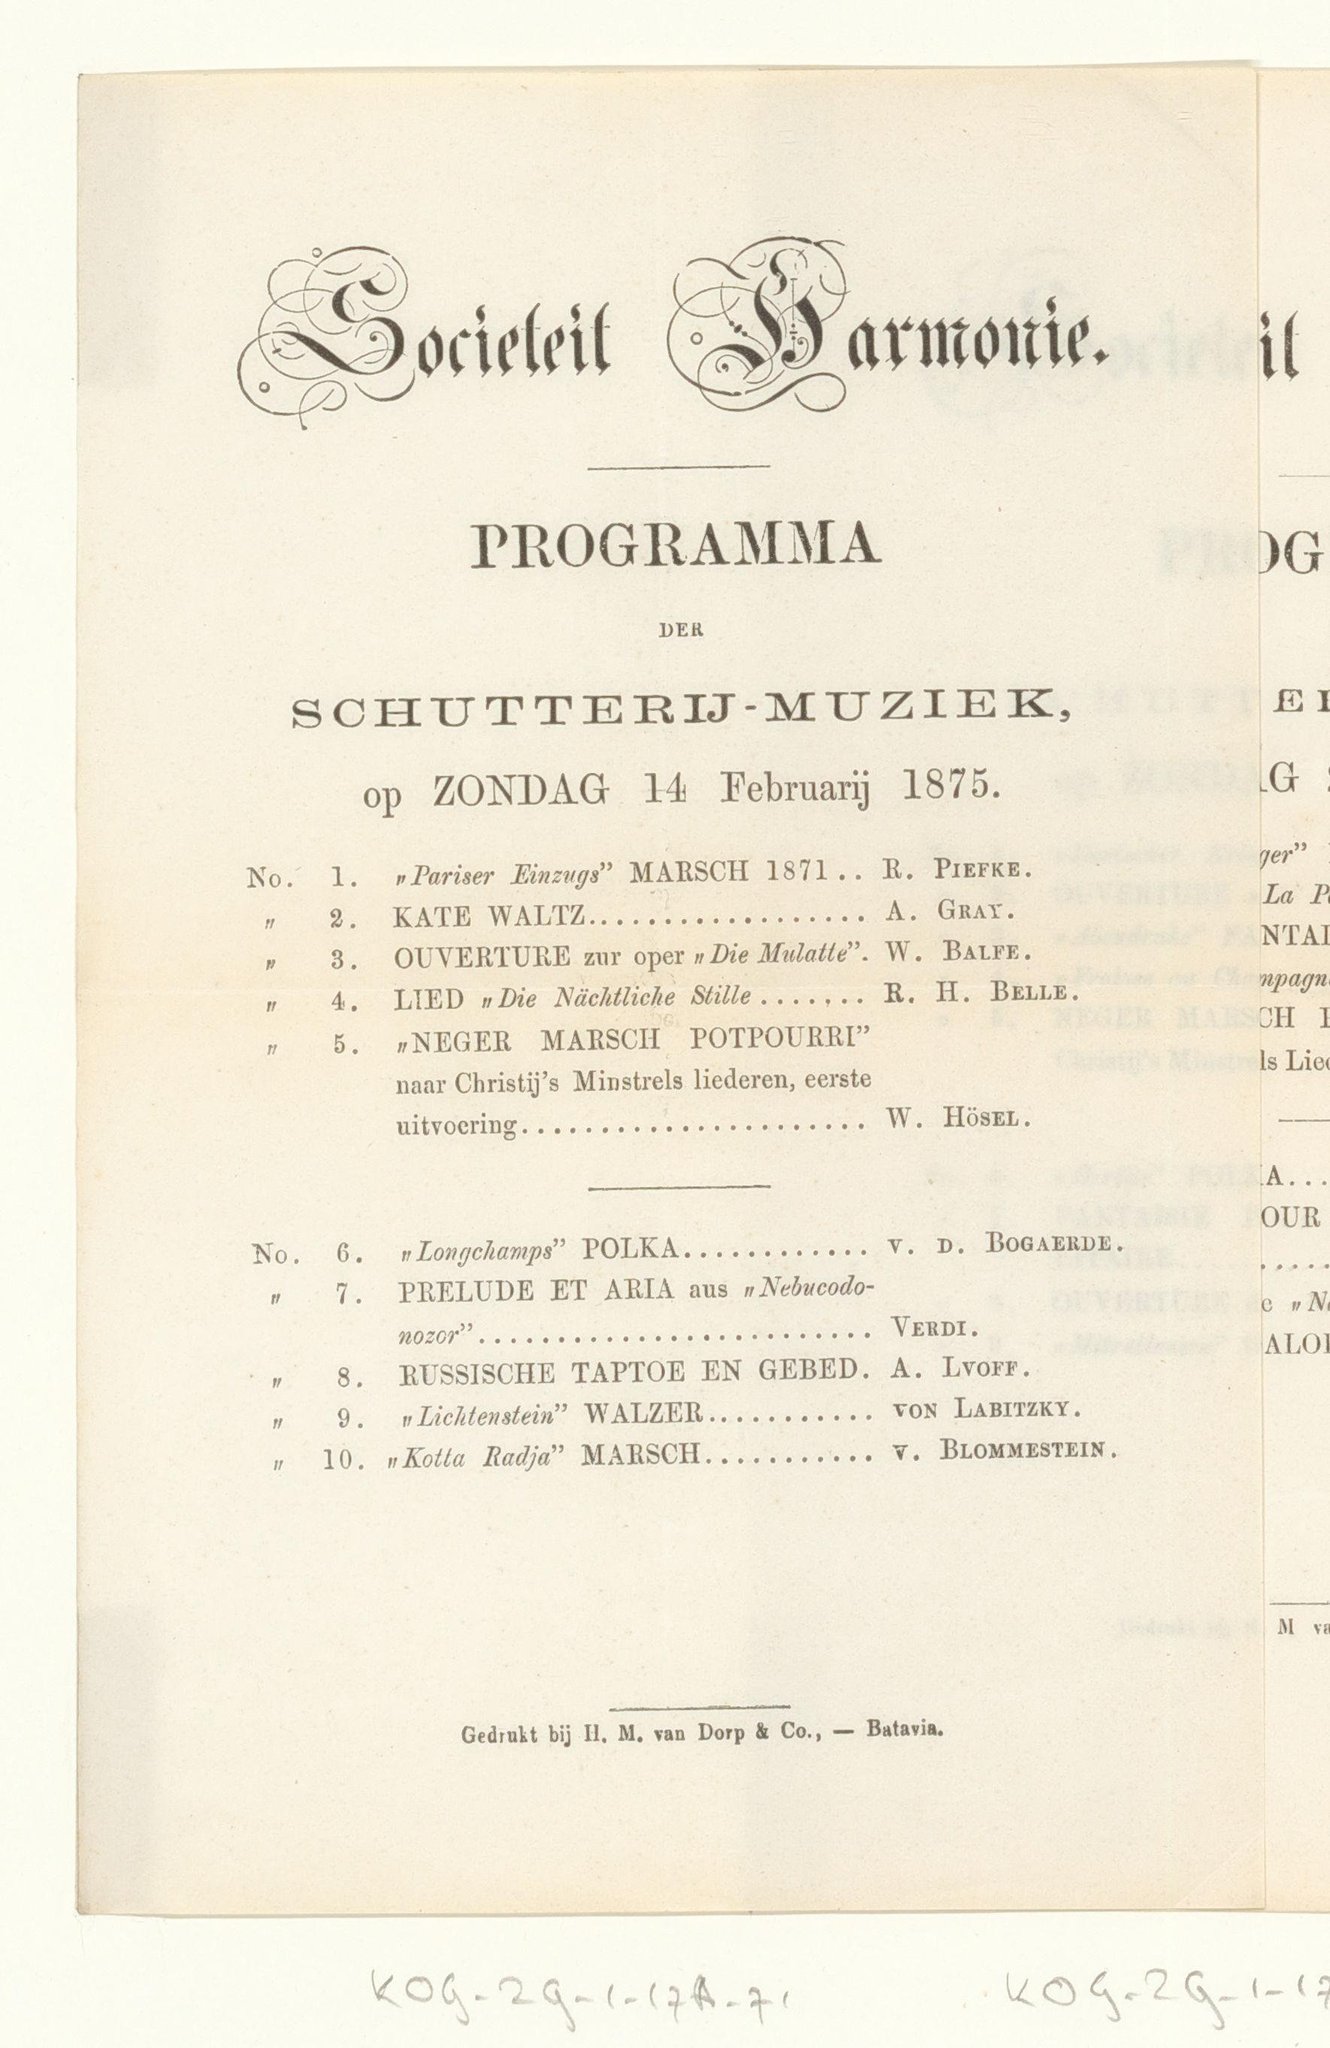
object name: programma, programmaboekje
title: Programma voor een concert in Sociëteit Harmonie op 14 februari 1875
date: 1875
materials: paper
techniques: letterpress printing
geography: batavia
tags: listening to music, large group of musicians, orchestra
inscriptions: collector's mark, collector's mark: Lugt 1641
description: Gedrukt programma voor een concert van schutterijmuziek in de Sociëteit Harmonie te Batavia op 14 februari 1875. Onderwerpsrubrieken binnen de Atlas Zeden en Gewoonten: Muziek en muziekinstrumenten: Varia.